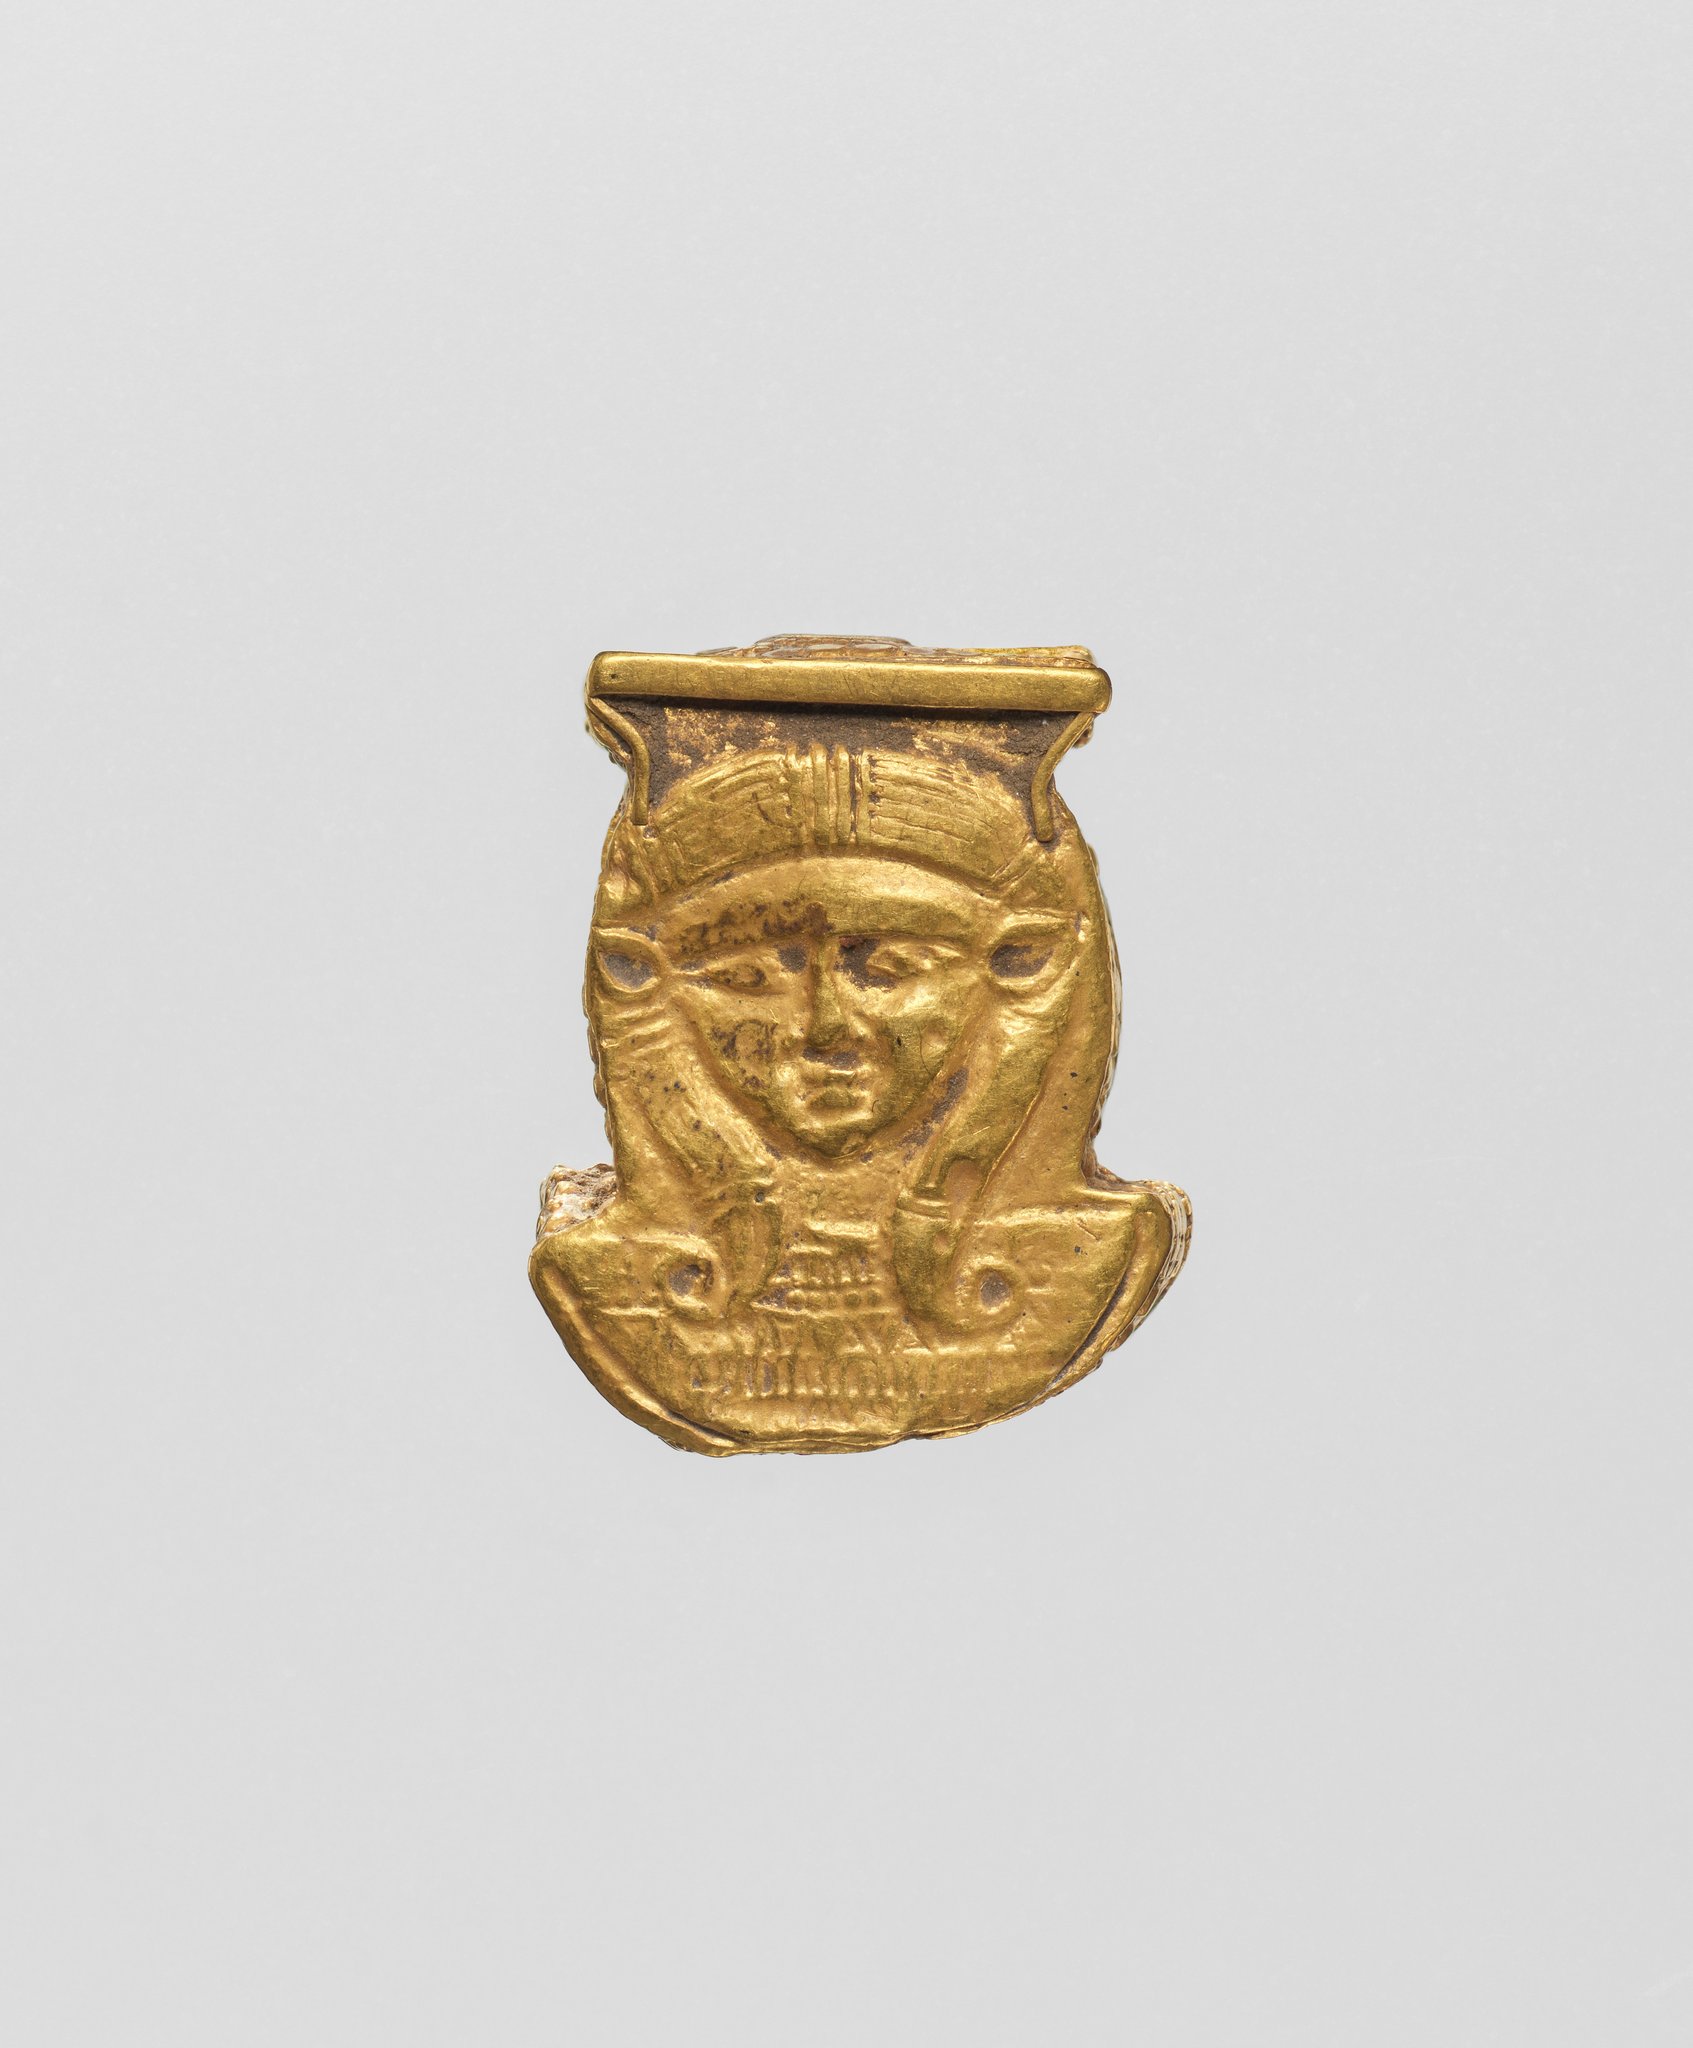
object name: bead, hathor head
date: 332-330 BCE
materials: gold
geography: egypt